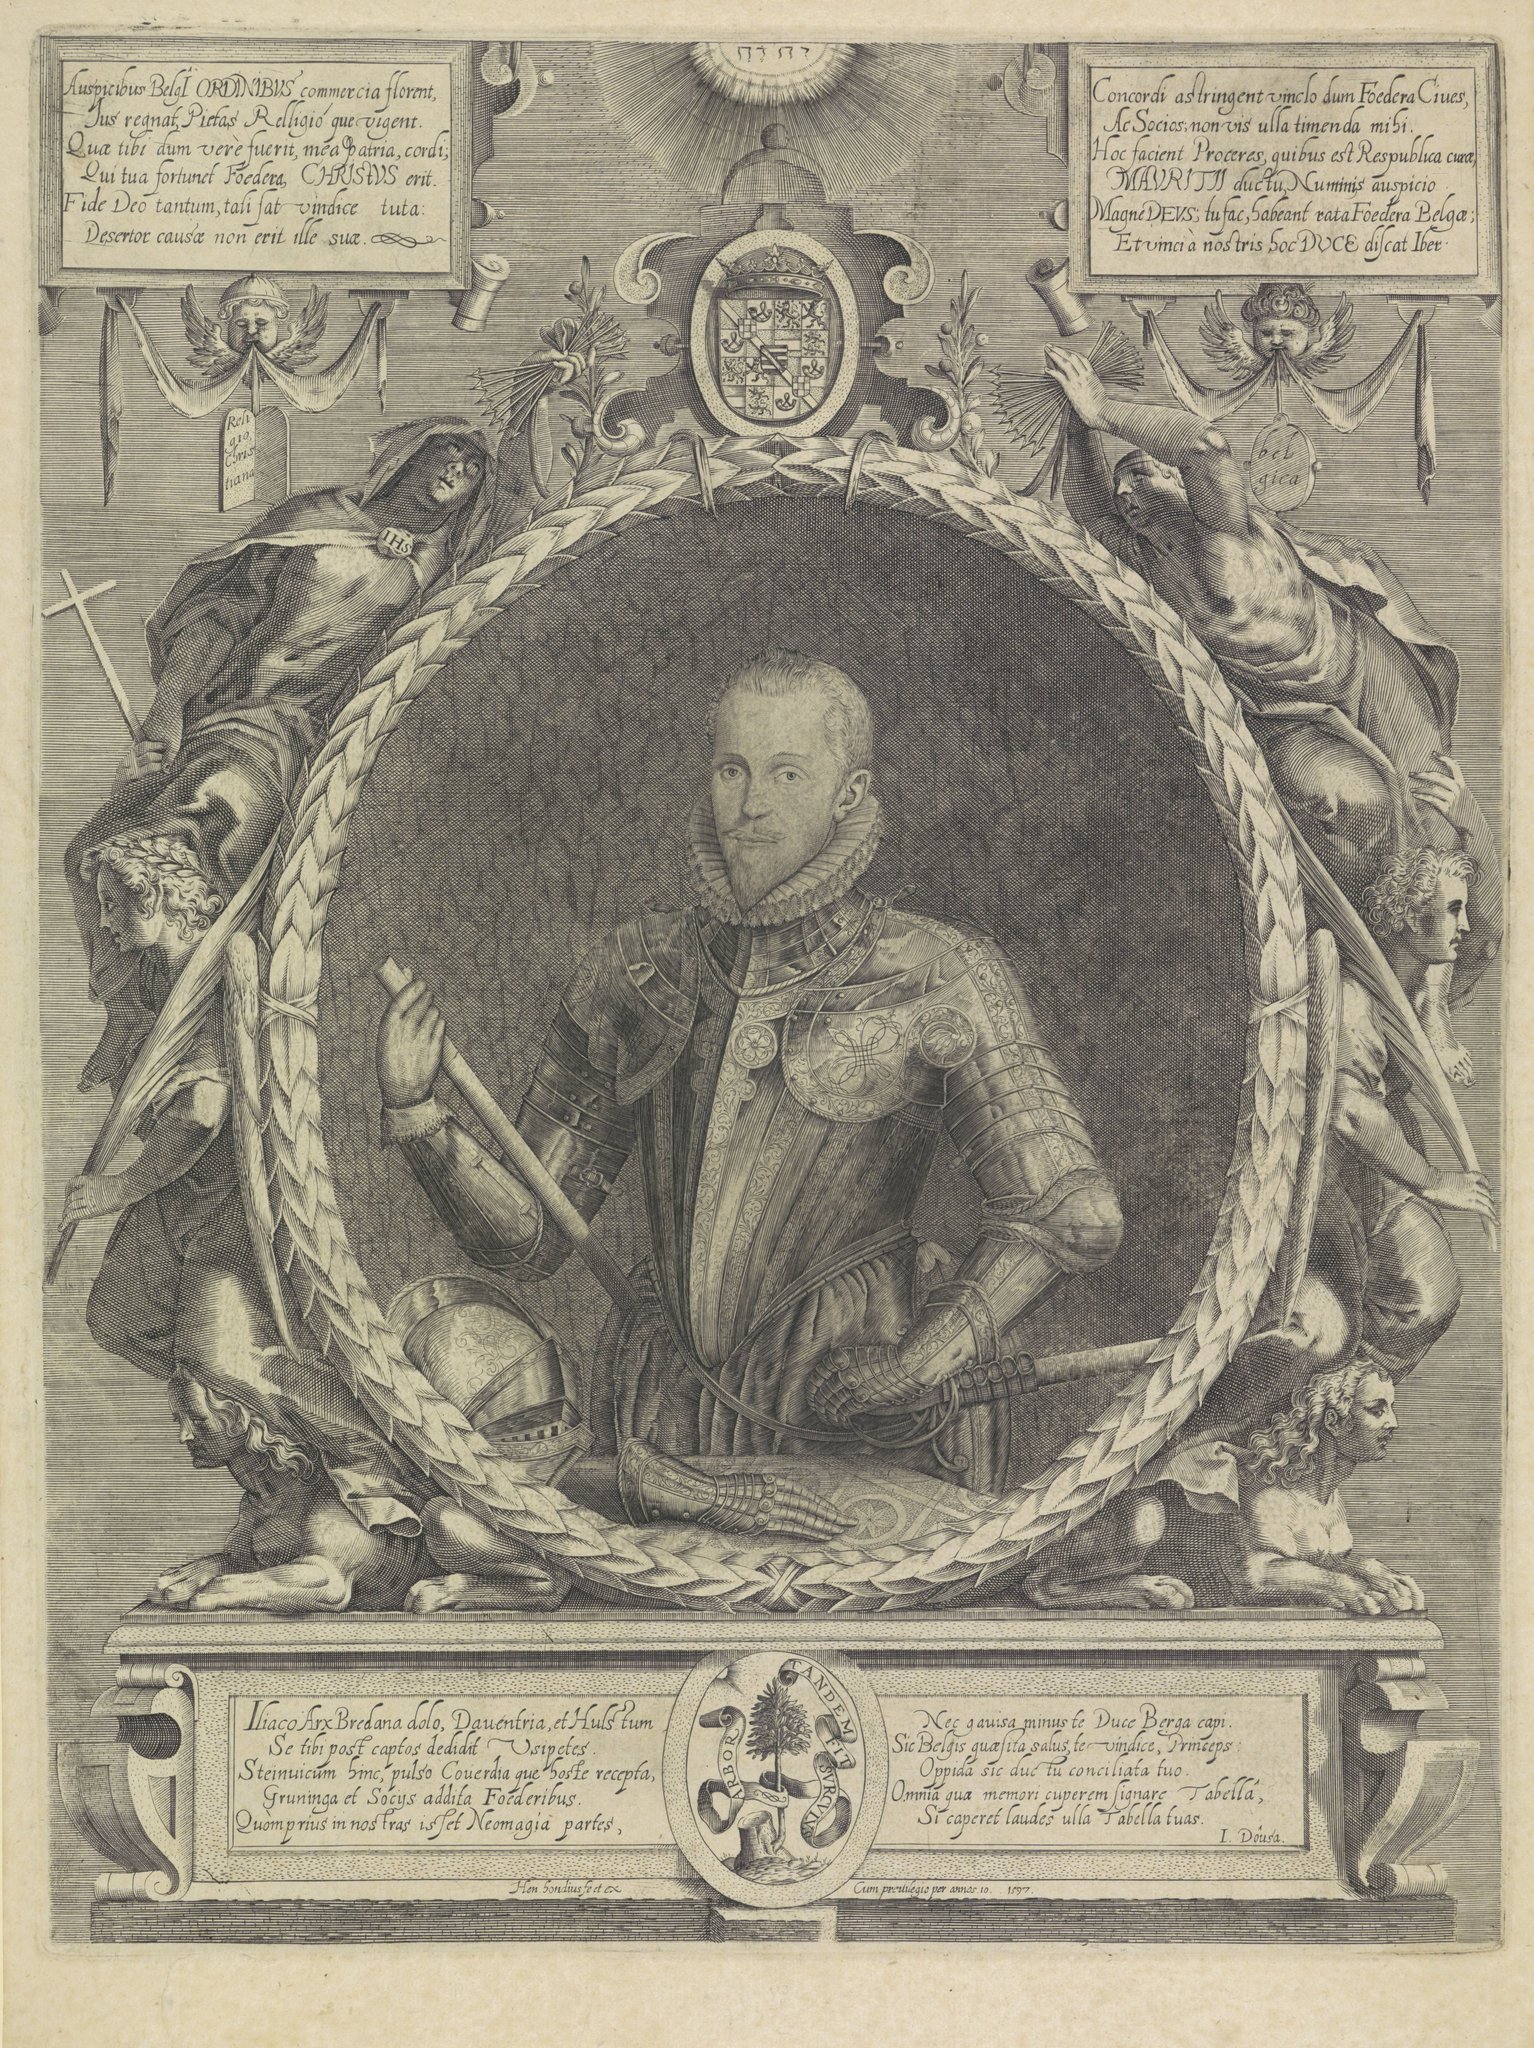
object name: print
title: Portret van Maurits, prins van Oranje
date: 1597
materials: paper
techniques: engraving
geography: the hague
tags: maurice (prince of orange)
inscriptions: collector's mark: Lugt 963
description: Portret van Maurits in een ovaal van eikenloof. Midden boven zijn wapen met daarboven een omstraald Tetragram. Aan weerszijden van het portret figuren met palmtakken en pijlen. Links-en rechtsonder twee sfinxen. Links- en rechtsboven cherubijnen en in twee cartouches zes regels Latijnse tekst. Op het voetstuk twee kolommen met elk vijf regels Latijnse tekst en de Oranjeboom met zijn lijfspreuk op een banderol.